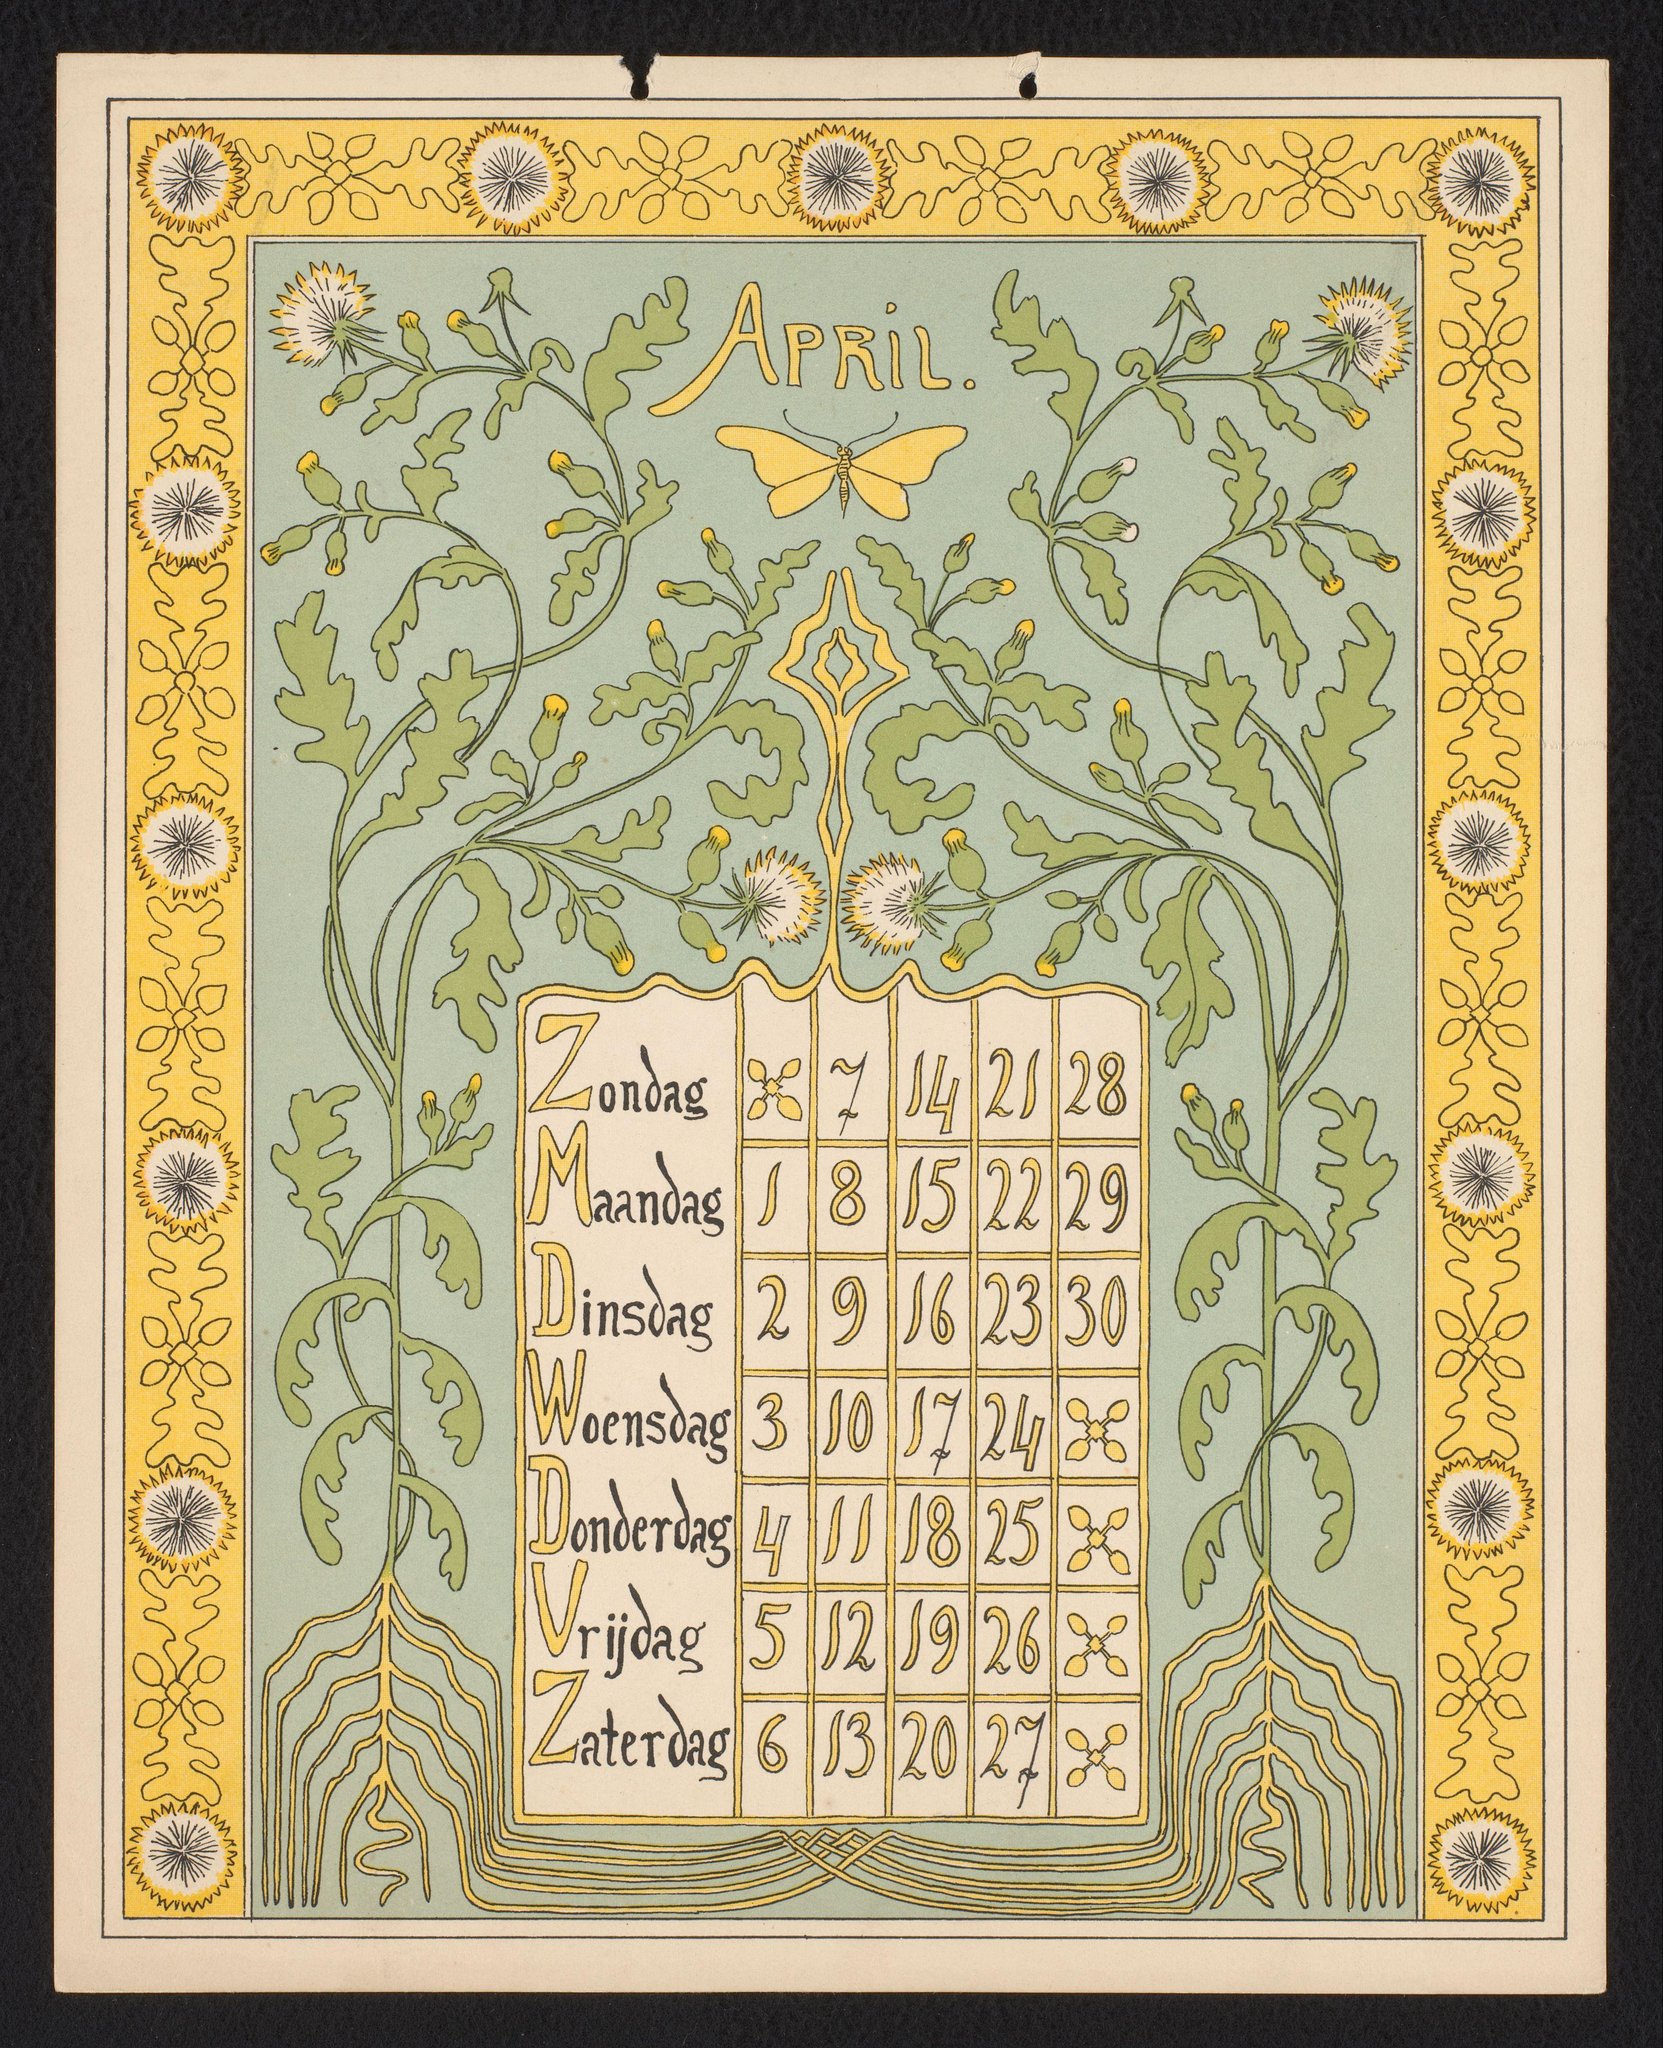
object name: calendar leaf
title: Kalenderblad voor april 1901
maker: c.a.j. van dishoeck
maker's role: publisher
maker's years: 1863-1931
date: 1900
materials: paper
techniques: lithograph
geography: amsterdam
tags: flowers, ornaments ~ art, calendar, almanac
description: Kalenderblad voor april 1901 van de kalender 'Bloem en Blad', met een randdecoratie van paardenbloem met vruchtpluis en uitgebloeide vruchten.